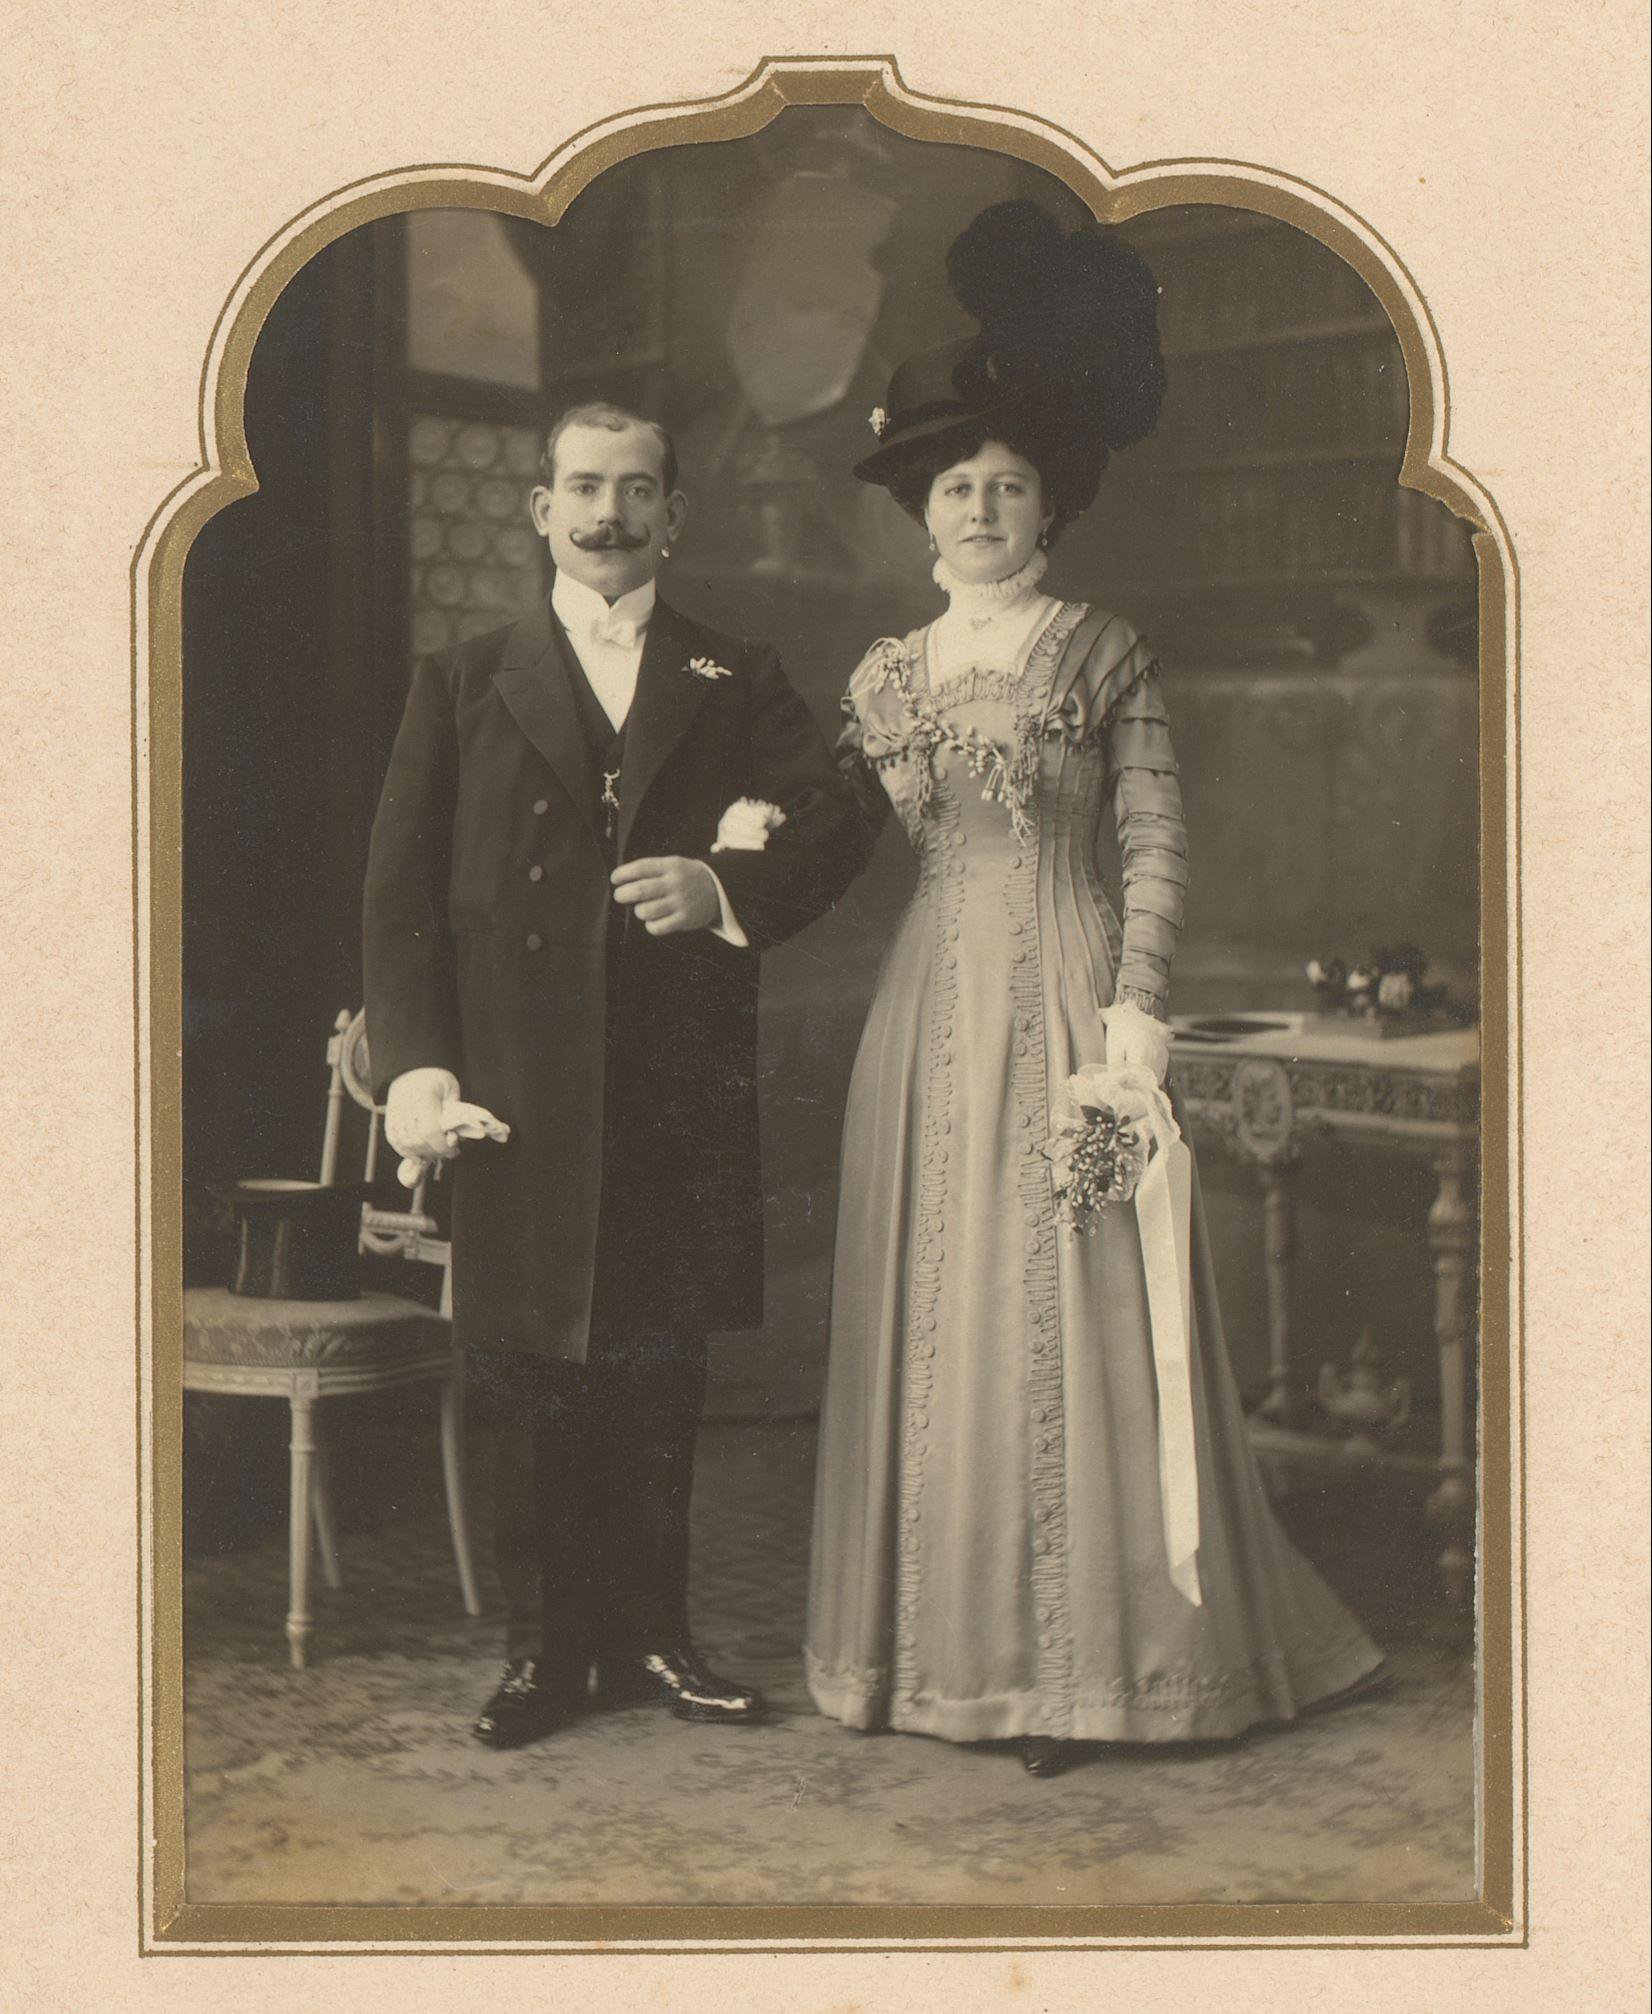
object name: album leaf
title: Portret van een staand echtpaar, vrouw met boeket en hoed, man met handschoenen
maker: leopold jacqmain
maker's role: fotograaf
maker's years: 1876-1951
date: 1890-1920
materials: cardboard, photographic support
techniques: gelatin silver print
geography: antwerp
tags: head-gear: cap, couple of lovers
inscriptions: inscription: ‘Photographie/ Jacqmain/ 113, Rue Carnot, 113/ Anvers (...)’